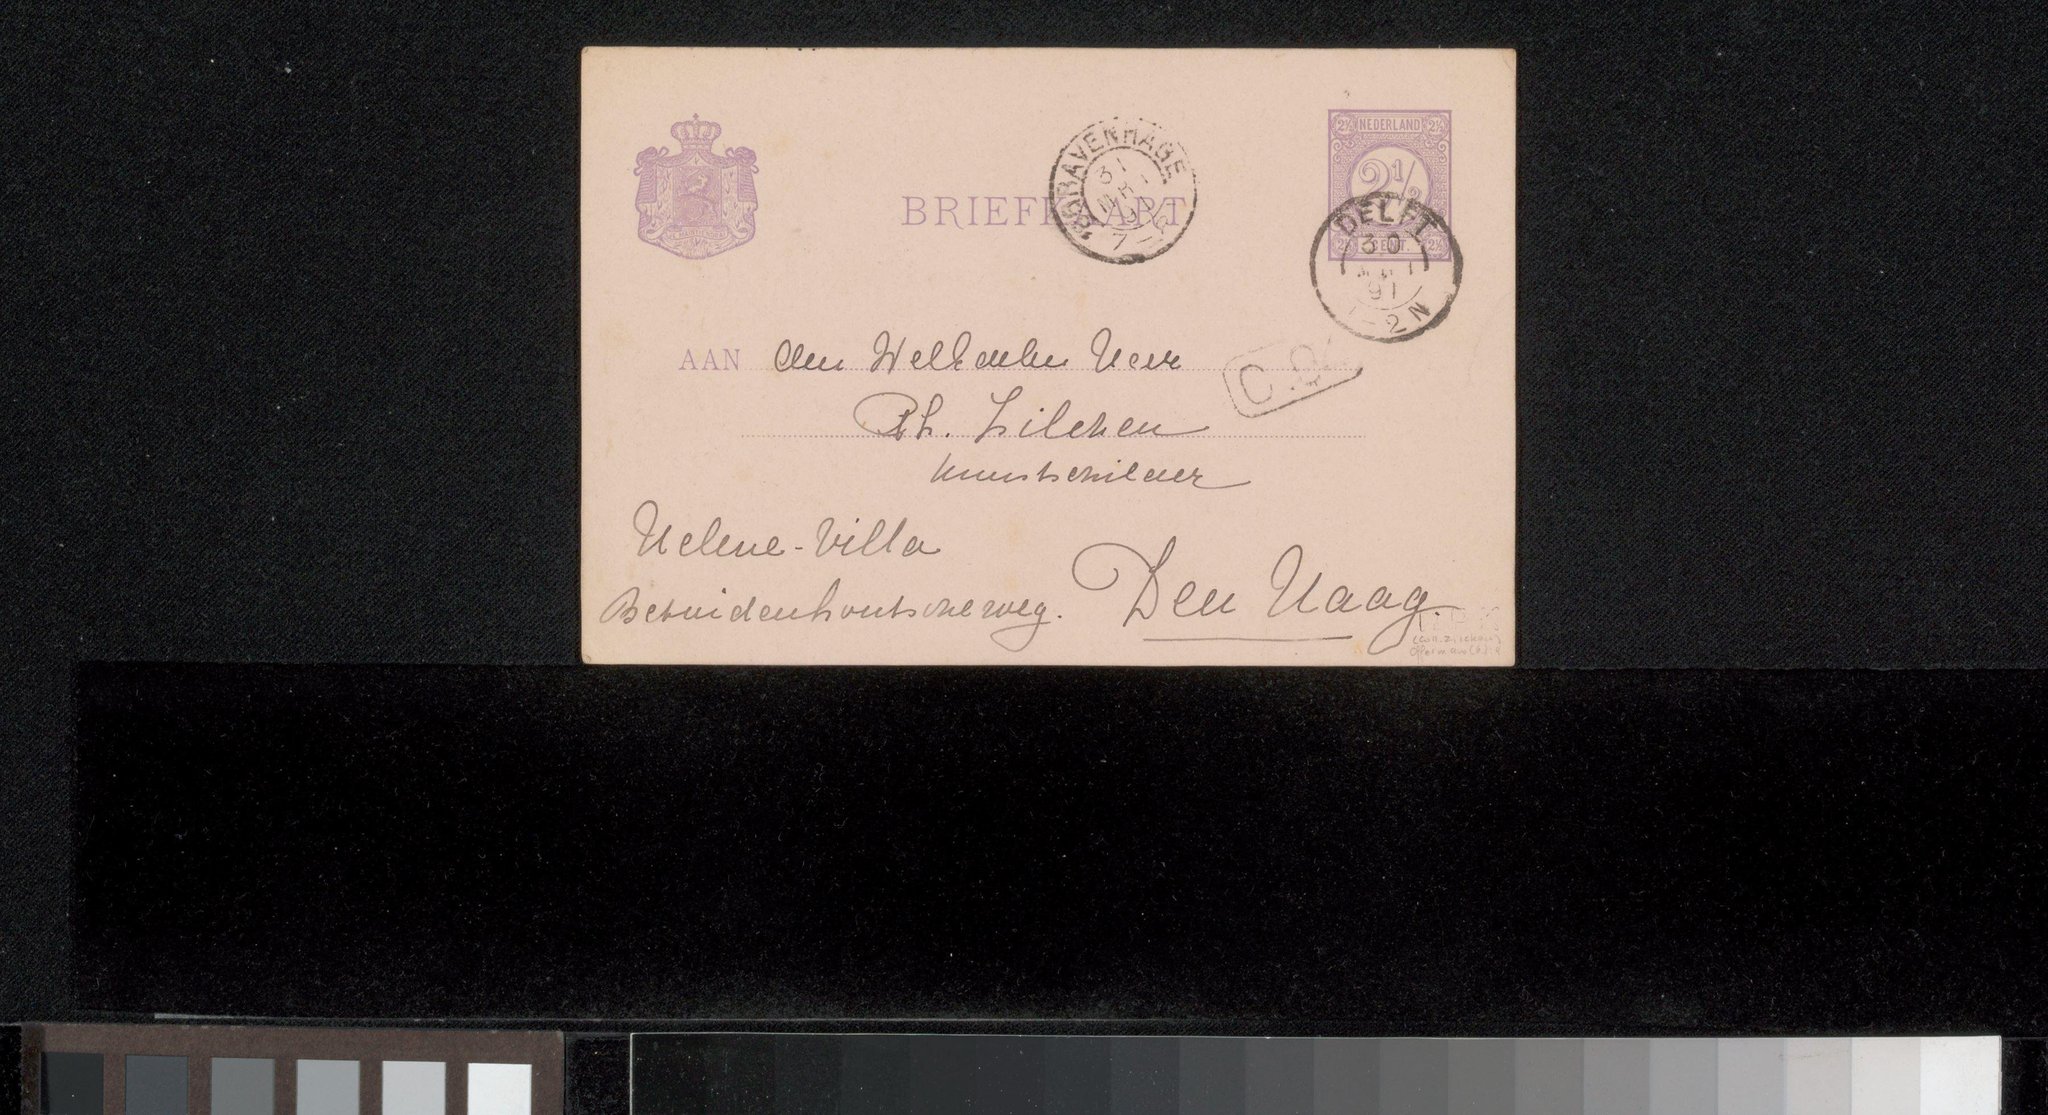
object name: postcard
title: Briefkaart aan Philip Zilcken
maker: g.j.d. offermans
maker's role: ceramicist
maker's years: 1857-1914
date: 1891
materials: cardboard, ink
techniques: pen, writing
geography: delft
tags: the hague, painter, draughtsman, philip zilcken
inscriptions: collector's mark: ‘RPK’